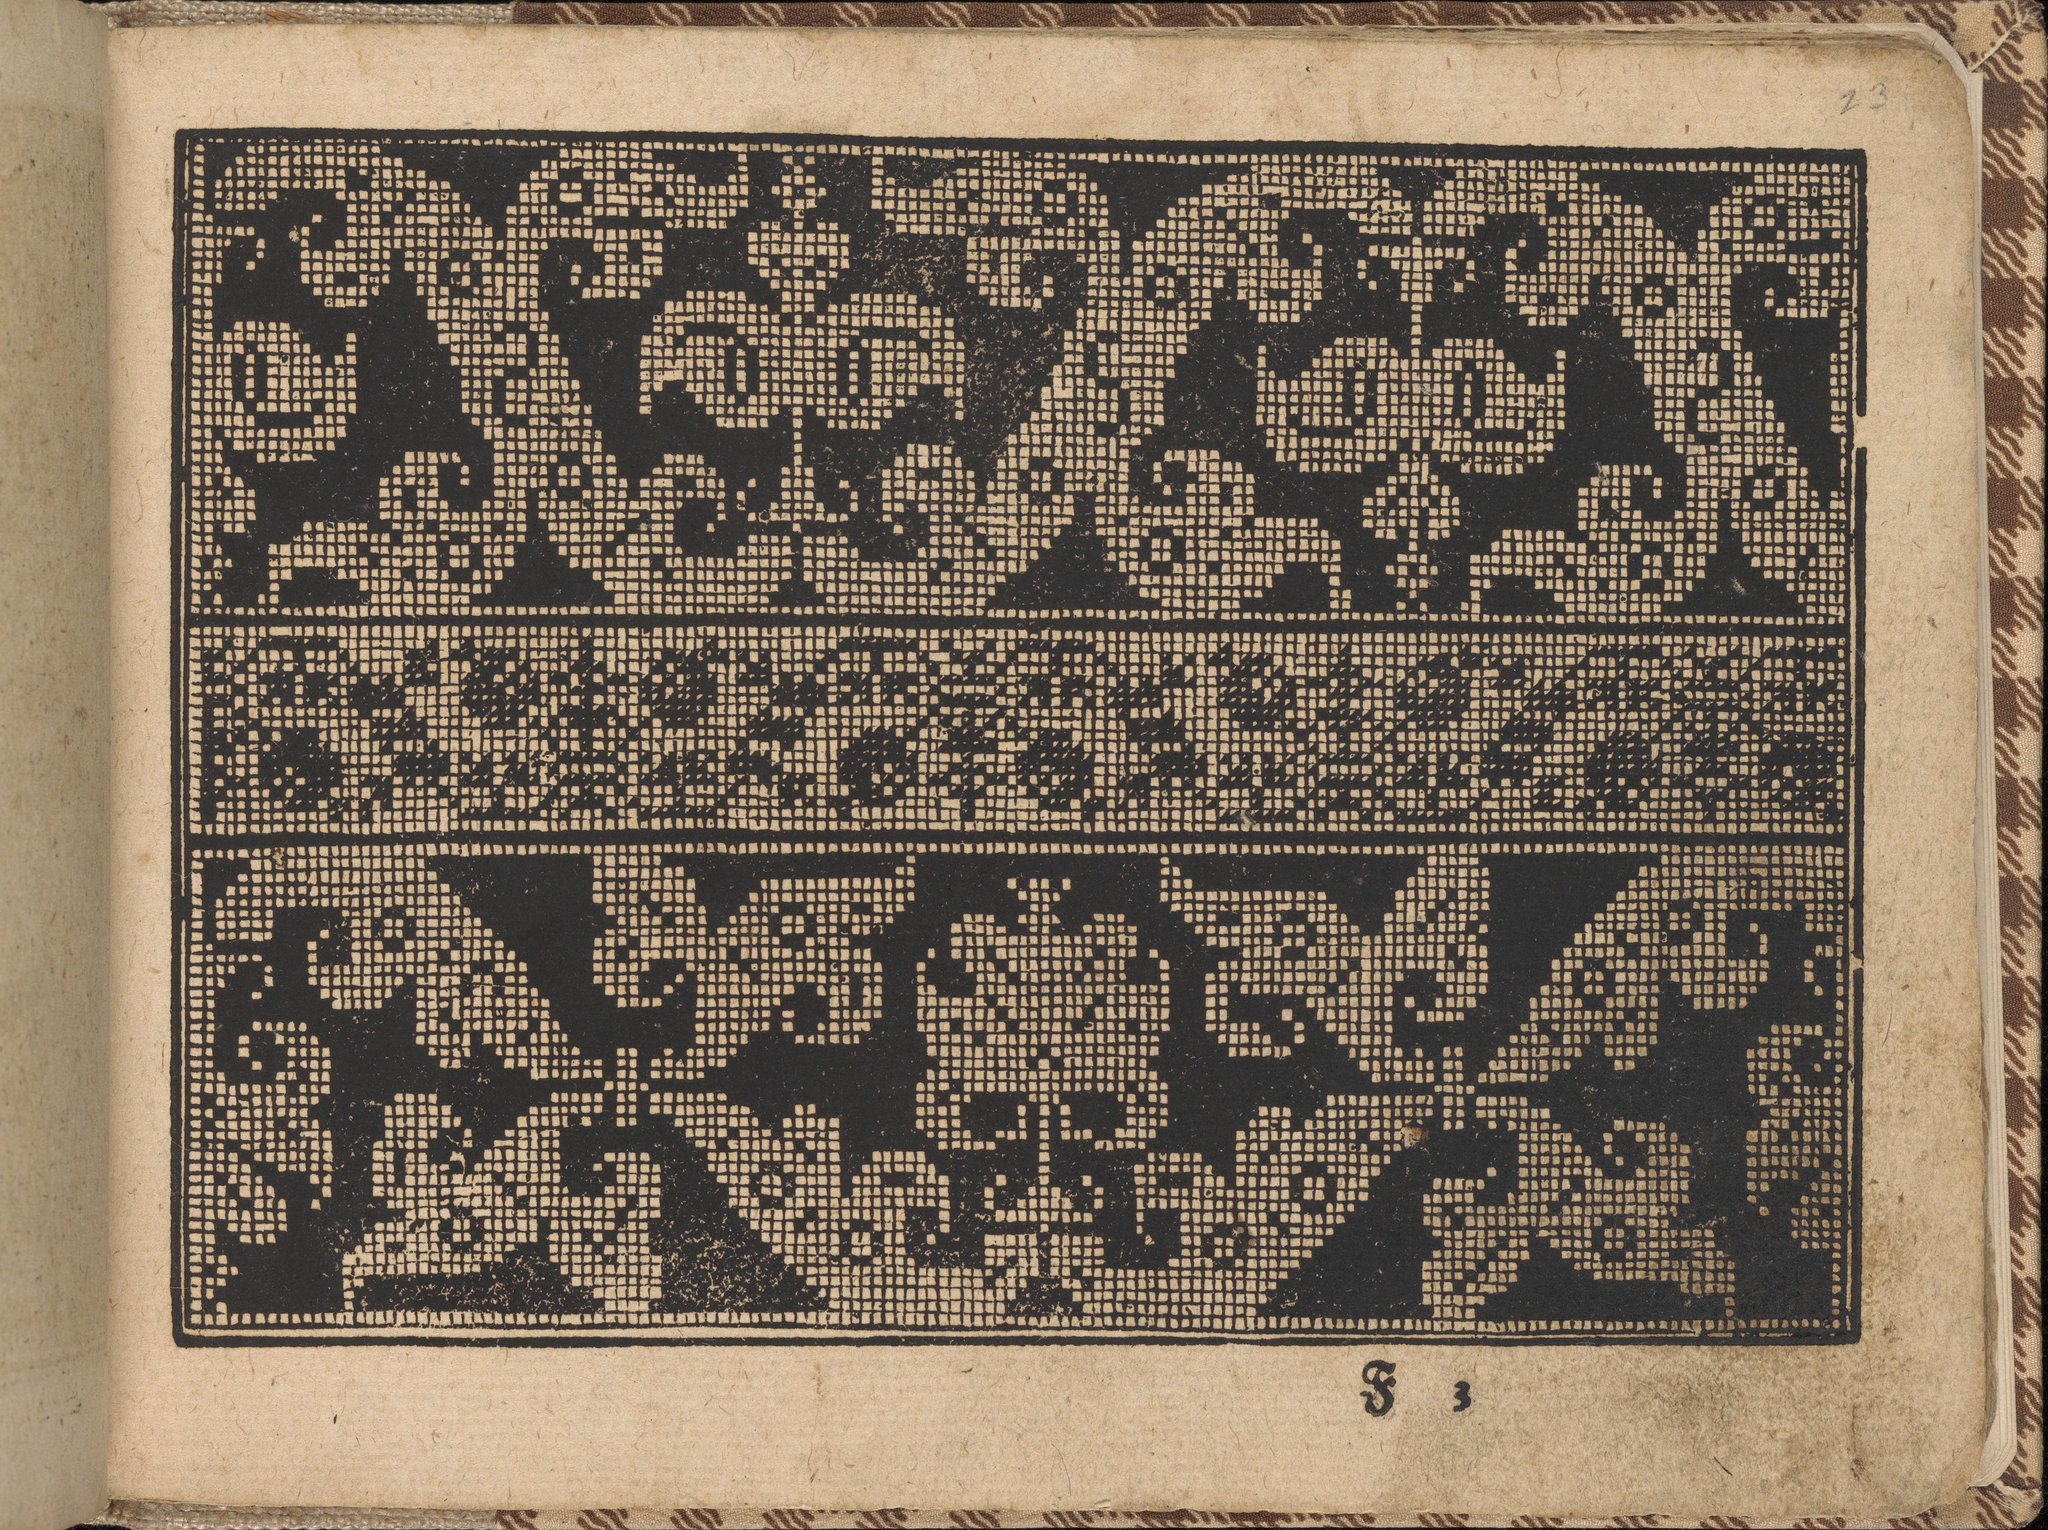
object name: book print ornament architecture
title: New Künstlichs Modelbuch (Page 23 recto)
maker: bernhard jobin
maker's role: publisher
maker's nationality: swiss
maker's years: 1535-1597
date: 1600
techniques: woodcut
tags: ornament